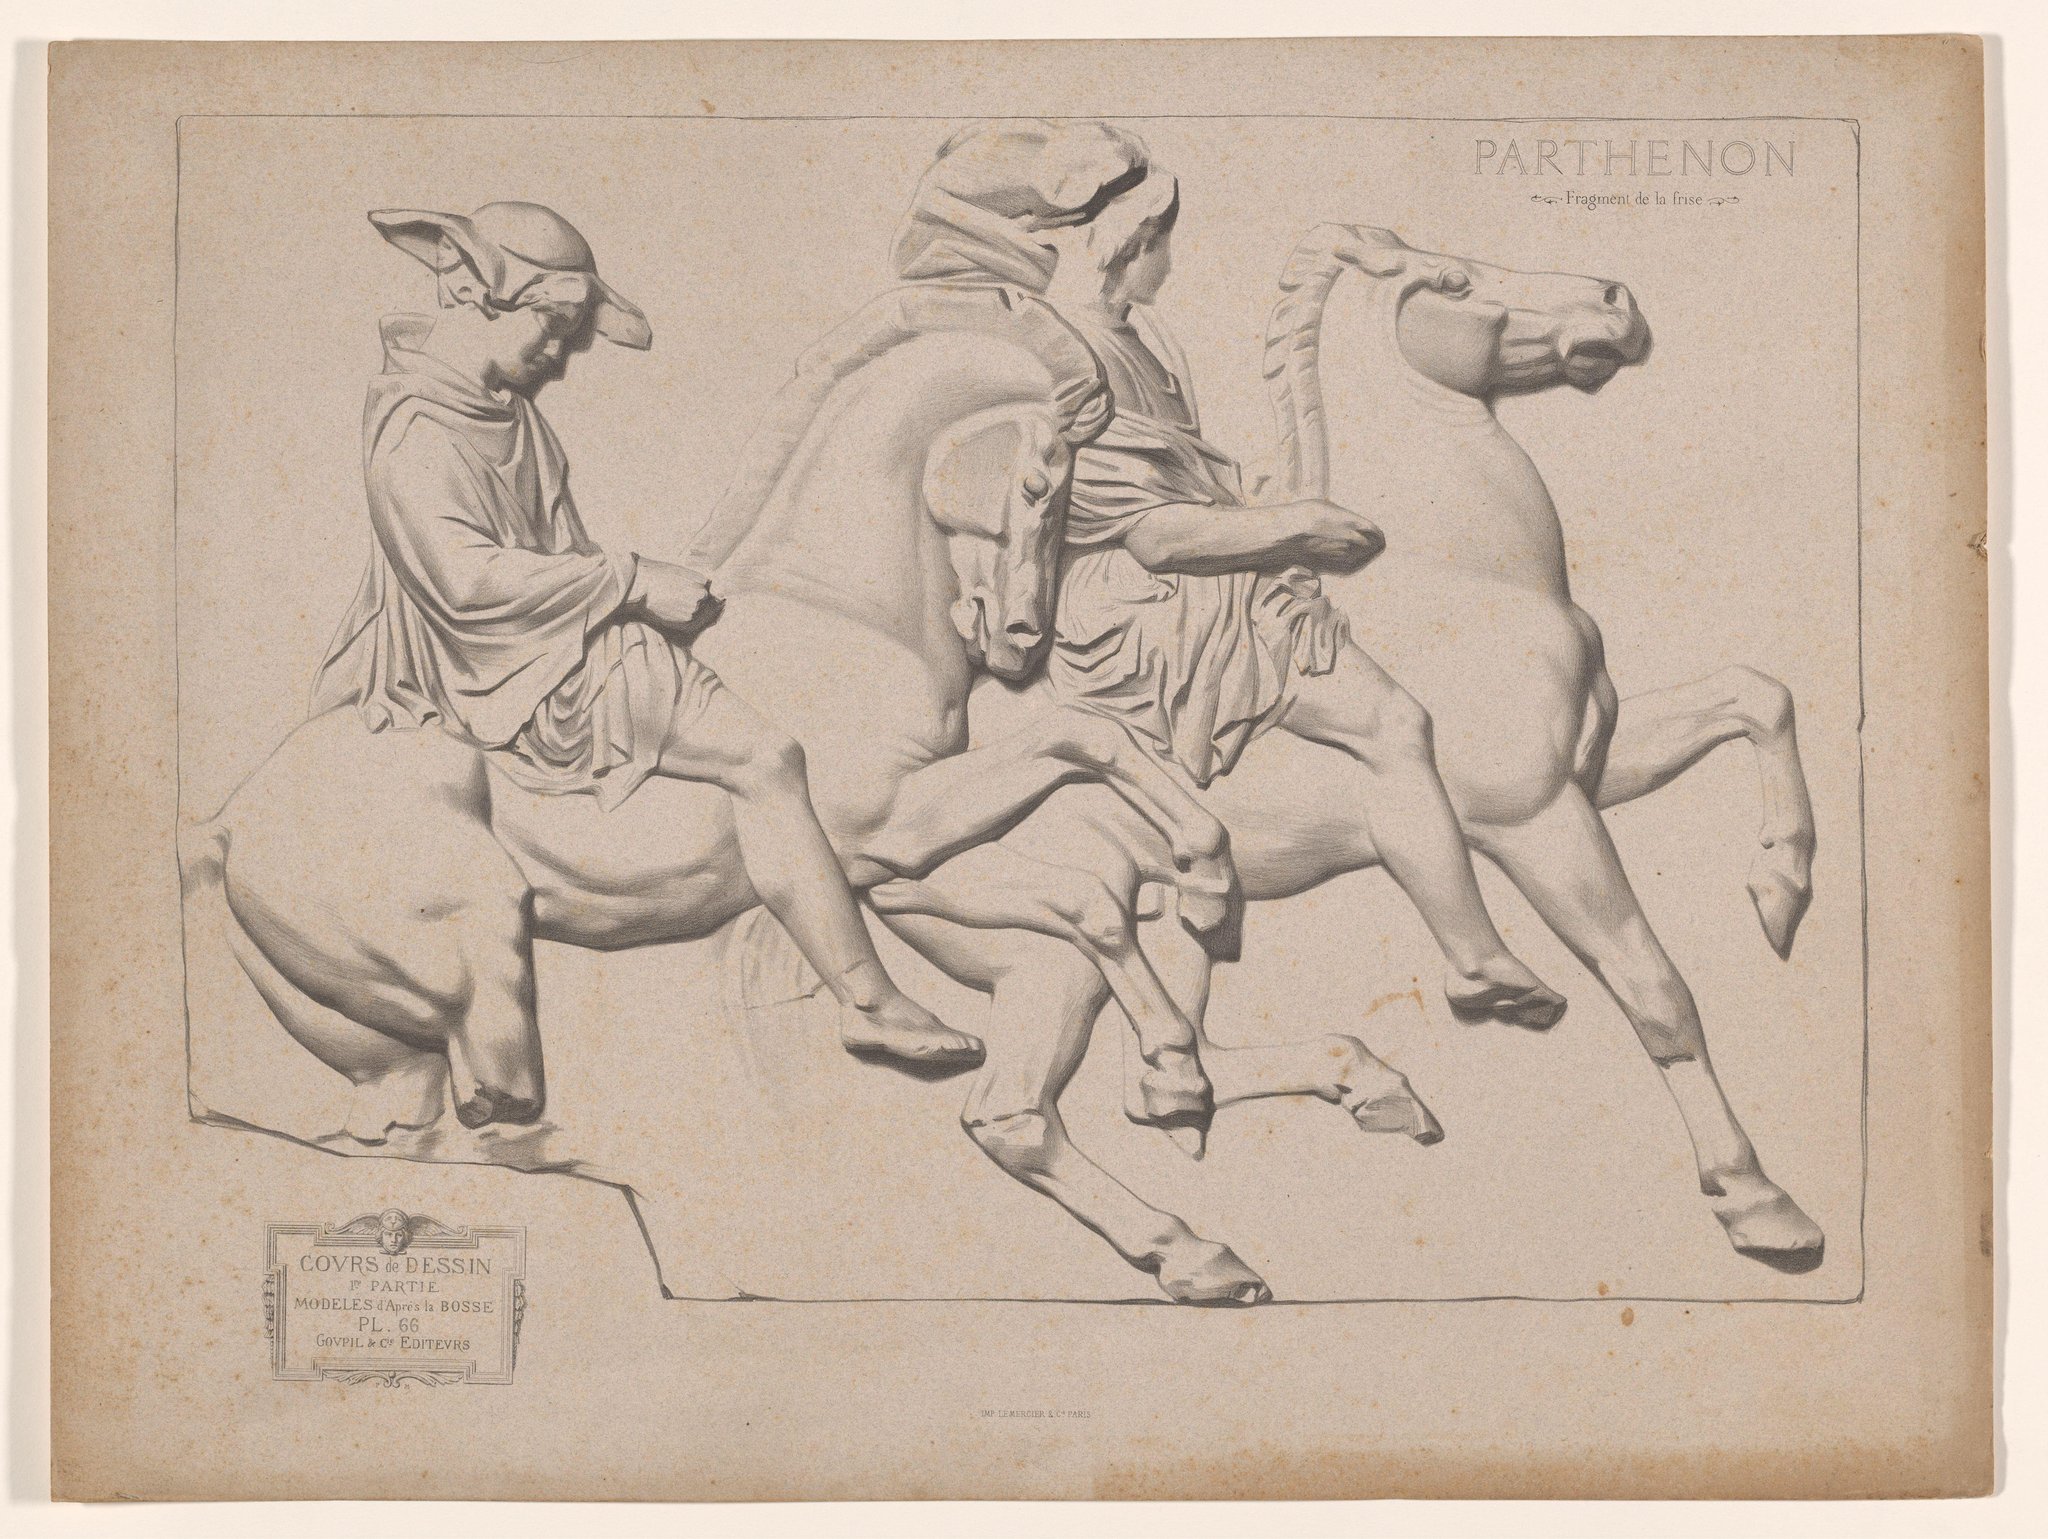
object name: print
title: Twee ruiters, deel van het fries van het Parthenon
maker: charles bargue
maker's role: print maker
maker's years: 1825-1883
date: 1866-1871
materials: paper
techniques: lithograph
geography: paris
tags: riding a horse, ass, or mule; rider, horseman, piece of sculpture, reproduction of a piece of sculpture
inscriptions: stamp: ‘VOSMAER’, check stamp: Lugt 1090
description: Onderdeel van het eerste deel van Charles Bargue's en Jean-Léon Gérôme's 'Cours de dessin' tekencursus, uitgegeven tussen 1866 en 1871.